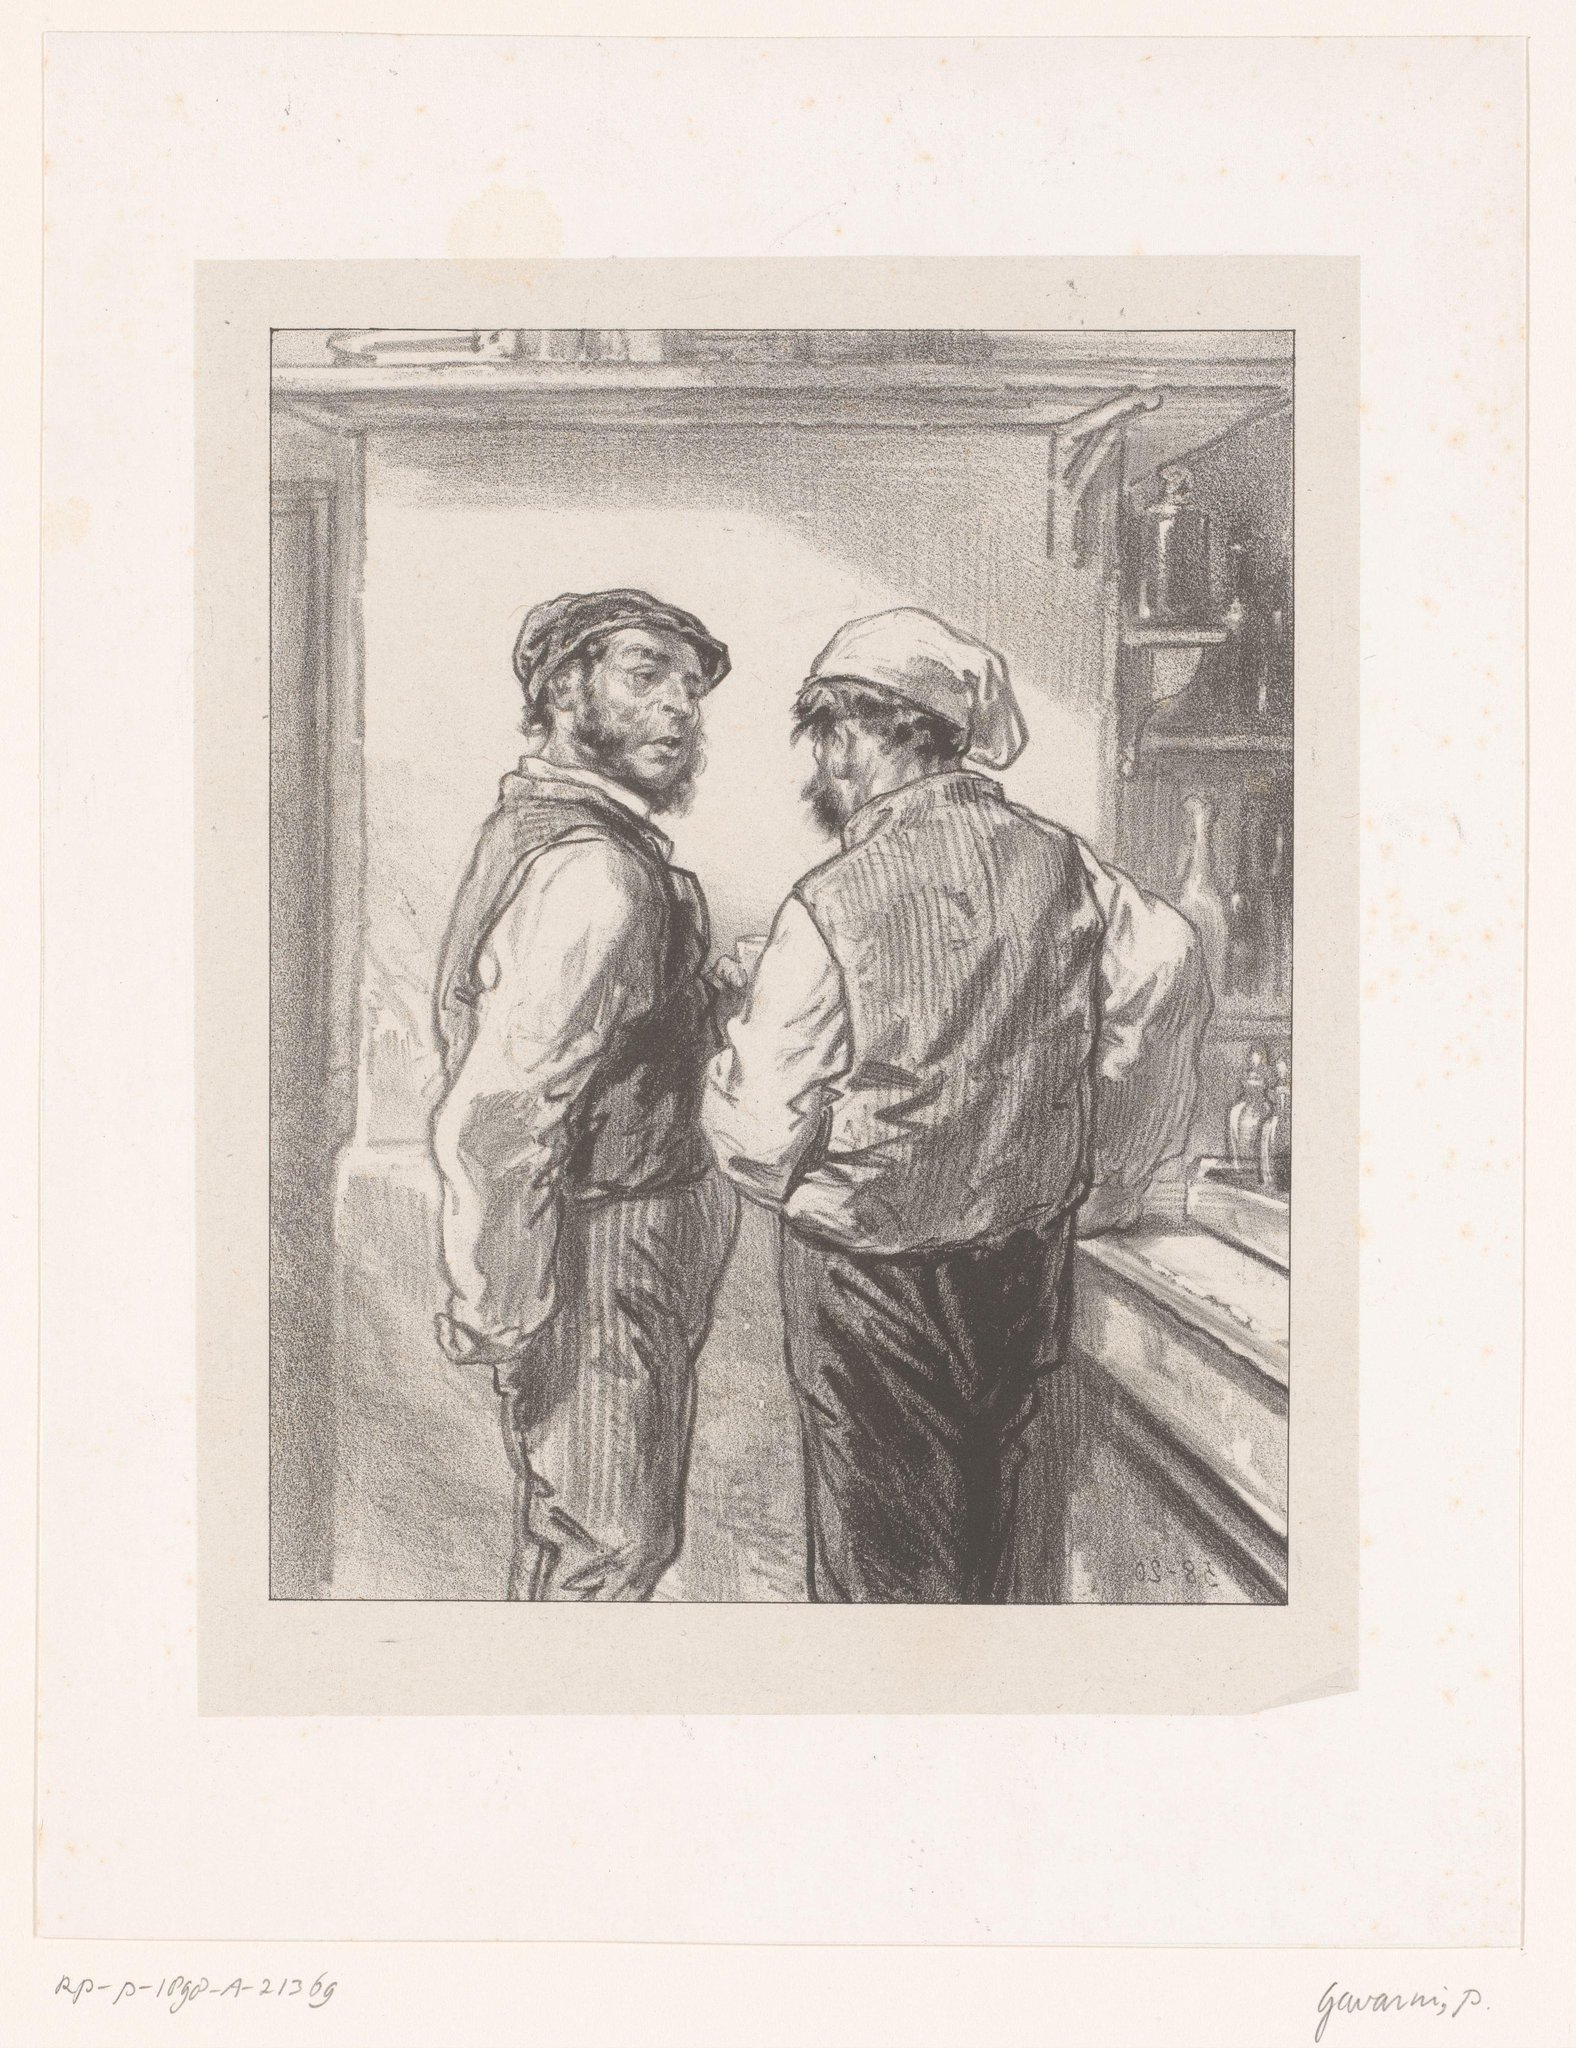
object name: cartoon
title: Twee mannen spreken elkaar in een café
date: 1858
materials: paper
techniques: lithograph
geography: paris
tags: inn, coffee-house, public house, etc., conversation, dialogue; conversation piece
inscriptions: collector's mark: Lugt 964